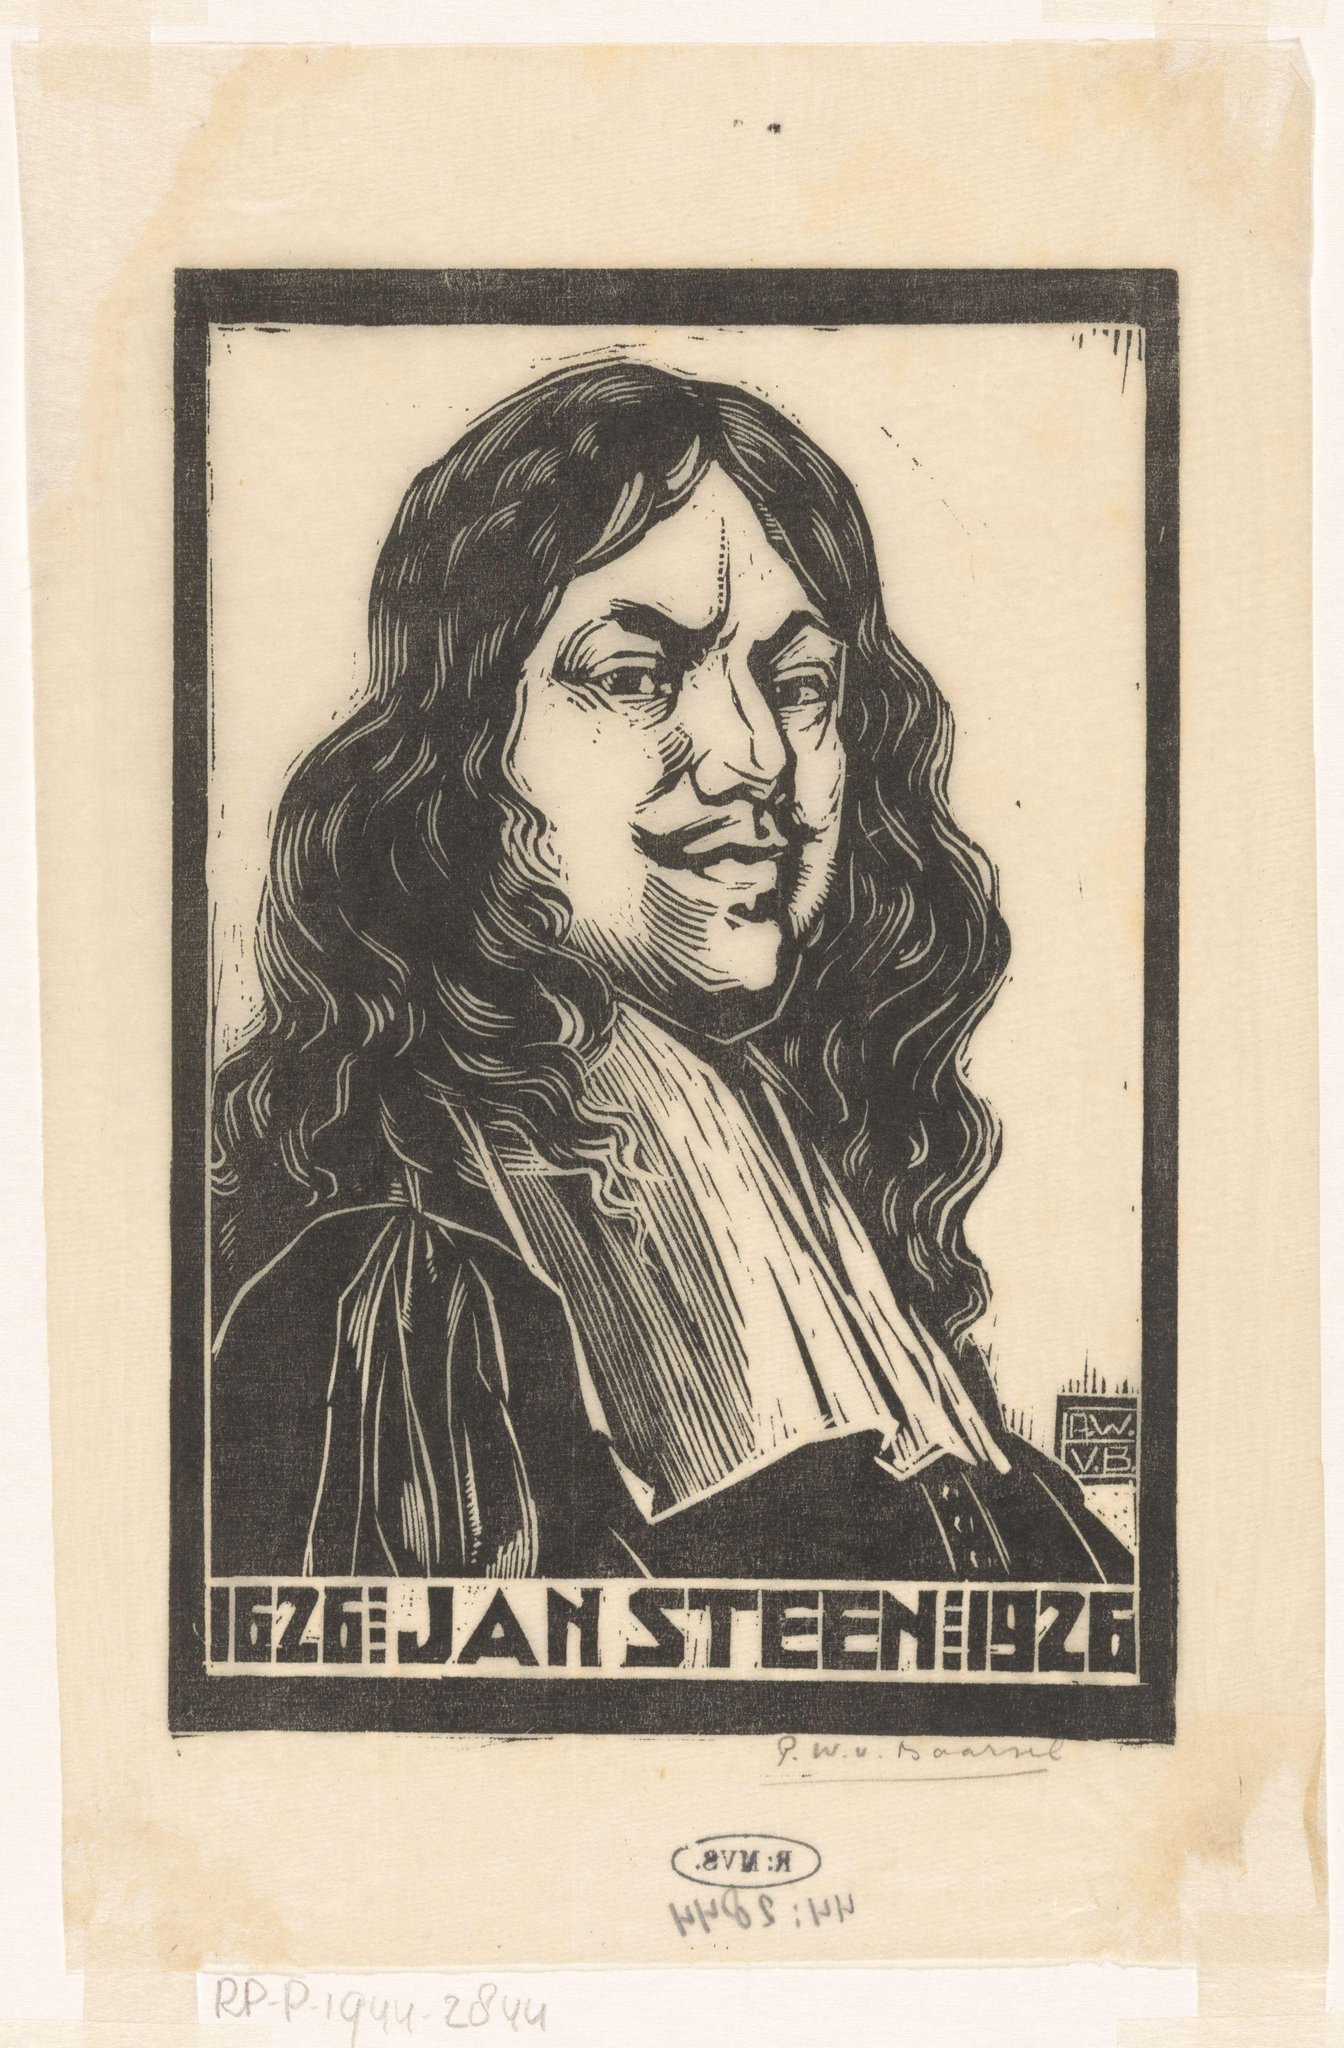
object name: print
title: Portret van Jan Steen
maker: pieter willem van baarsel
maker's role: draughtsman, painter, print maker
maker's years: 1879-1949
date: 1926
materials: paper, ink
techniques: woodcut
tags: leiden, painter, print maker, jan havicksz. steen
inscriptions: title: ‘1626: JAN STEEN: 1926’, monogram: ‘P.W.v.B.’, collector's mark: Lugt 2228, signature: ‘P.W.v. Baarsel’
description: Man ten halven lijve, met lang haar en een snor, naar het zelfportret van Jan Steen uit 1626.